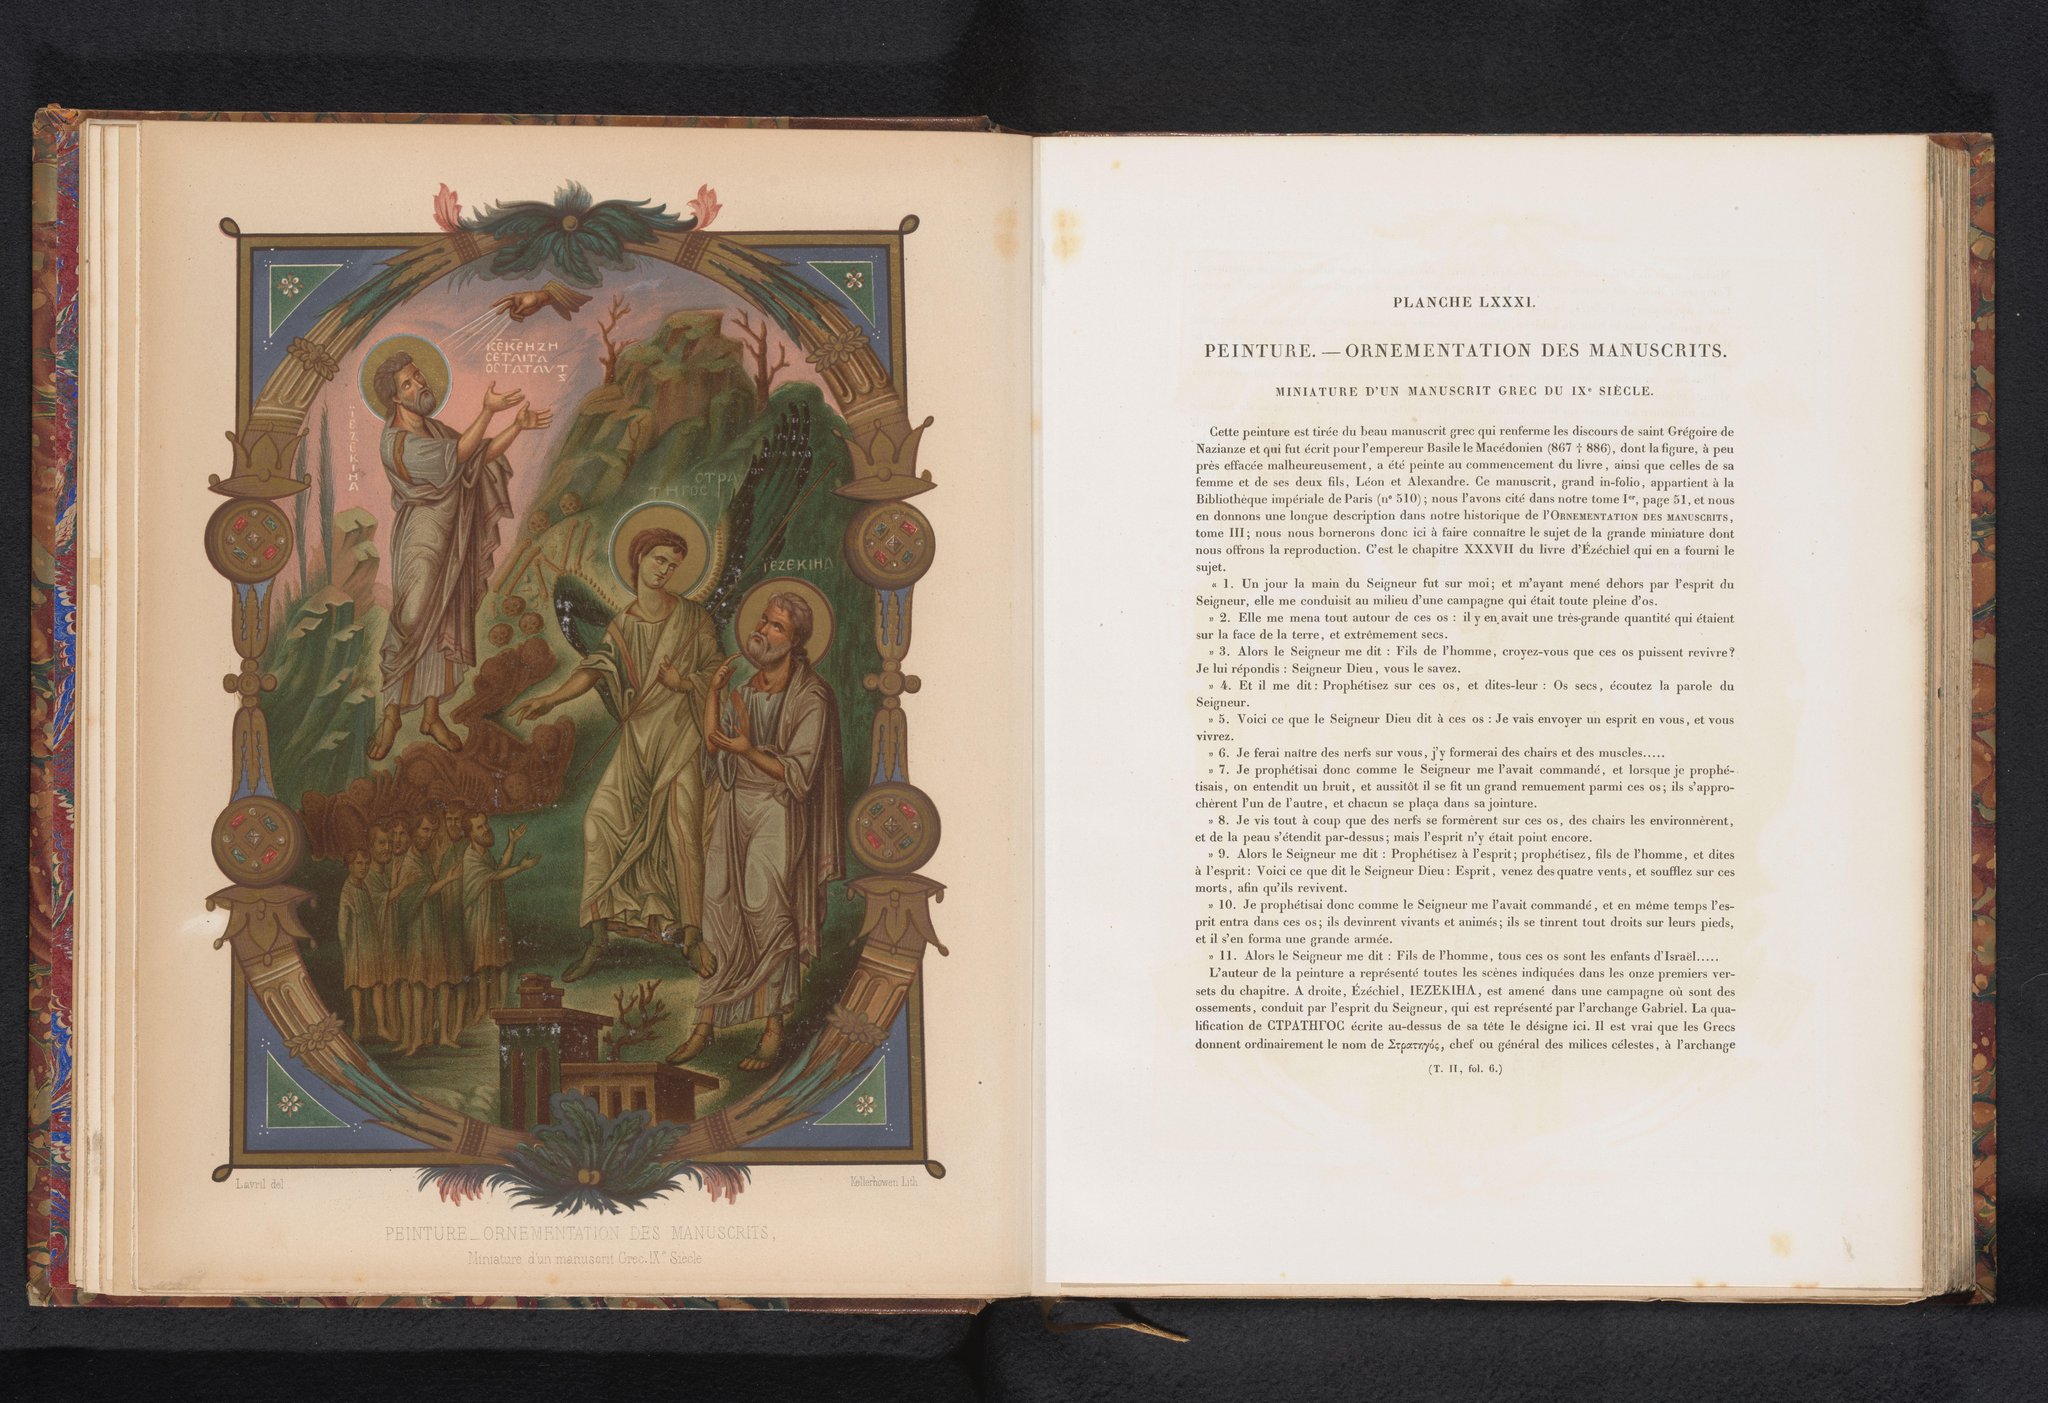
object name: reproduction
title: Reproductie van een verluchte pagina met een voorstelling uit het boek van Ezechiël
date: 1859-1864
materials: paper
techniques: chromolithography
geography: paris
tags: painting (including book-illumination, miniature-painting), the book of ezekiel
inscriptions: name: ‘Lavril del./ Kellerhowen Lith’